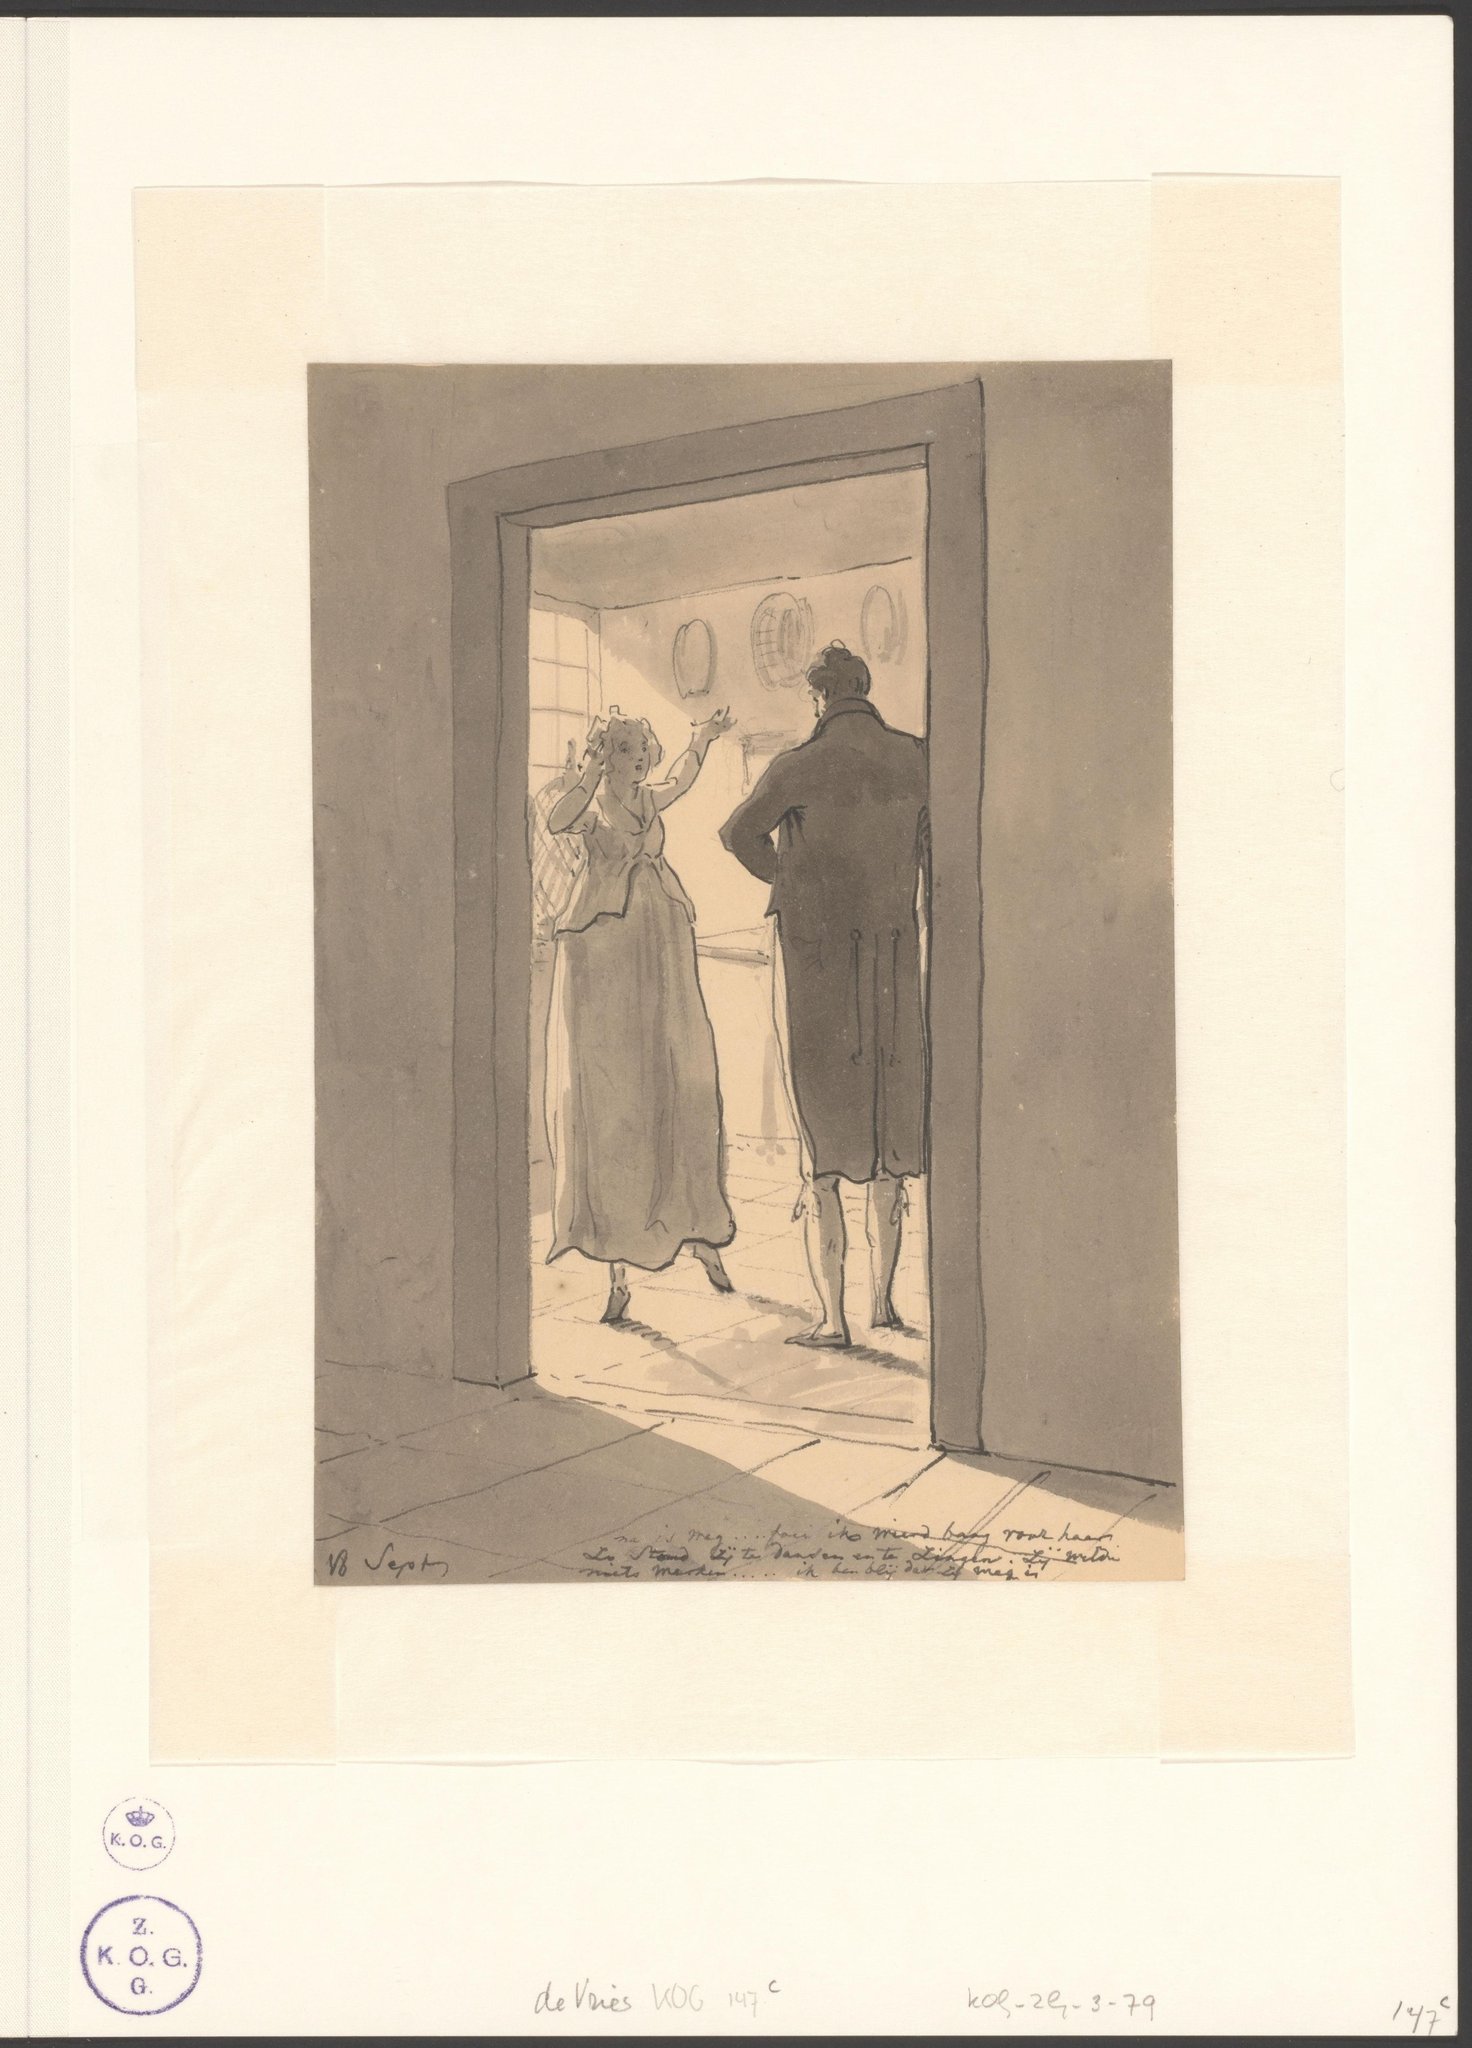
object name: drawing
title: Koppel in de keuken bespreekt de vermissing van hun moeder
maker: christiaan andriessen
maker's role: draughtsman, print maker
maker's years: 1775-1846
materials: ink, paper, pencil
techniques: brush, pen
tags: confusion, bewilderment, panic; 'perturbatione' (ripa), kitchen-interior, interior of the house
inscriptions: inscription: ‘18 Sept ma is weg... (...)’, collector's mark: Lugt 1641, inscription:, collector's mark: Lugt 1641a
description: Dagboekblad uit het getekende dagboek dat Christiaan Andriessen bijhield van 1805 tot en met 1808.